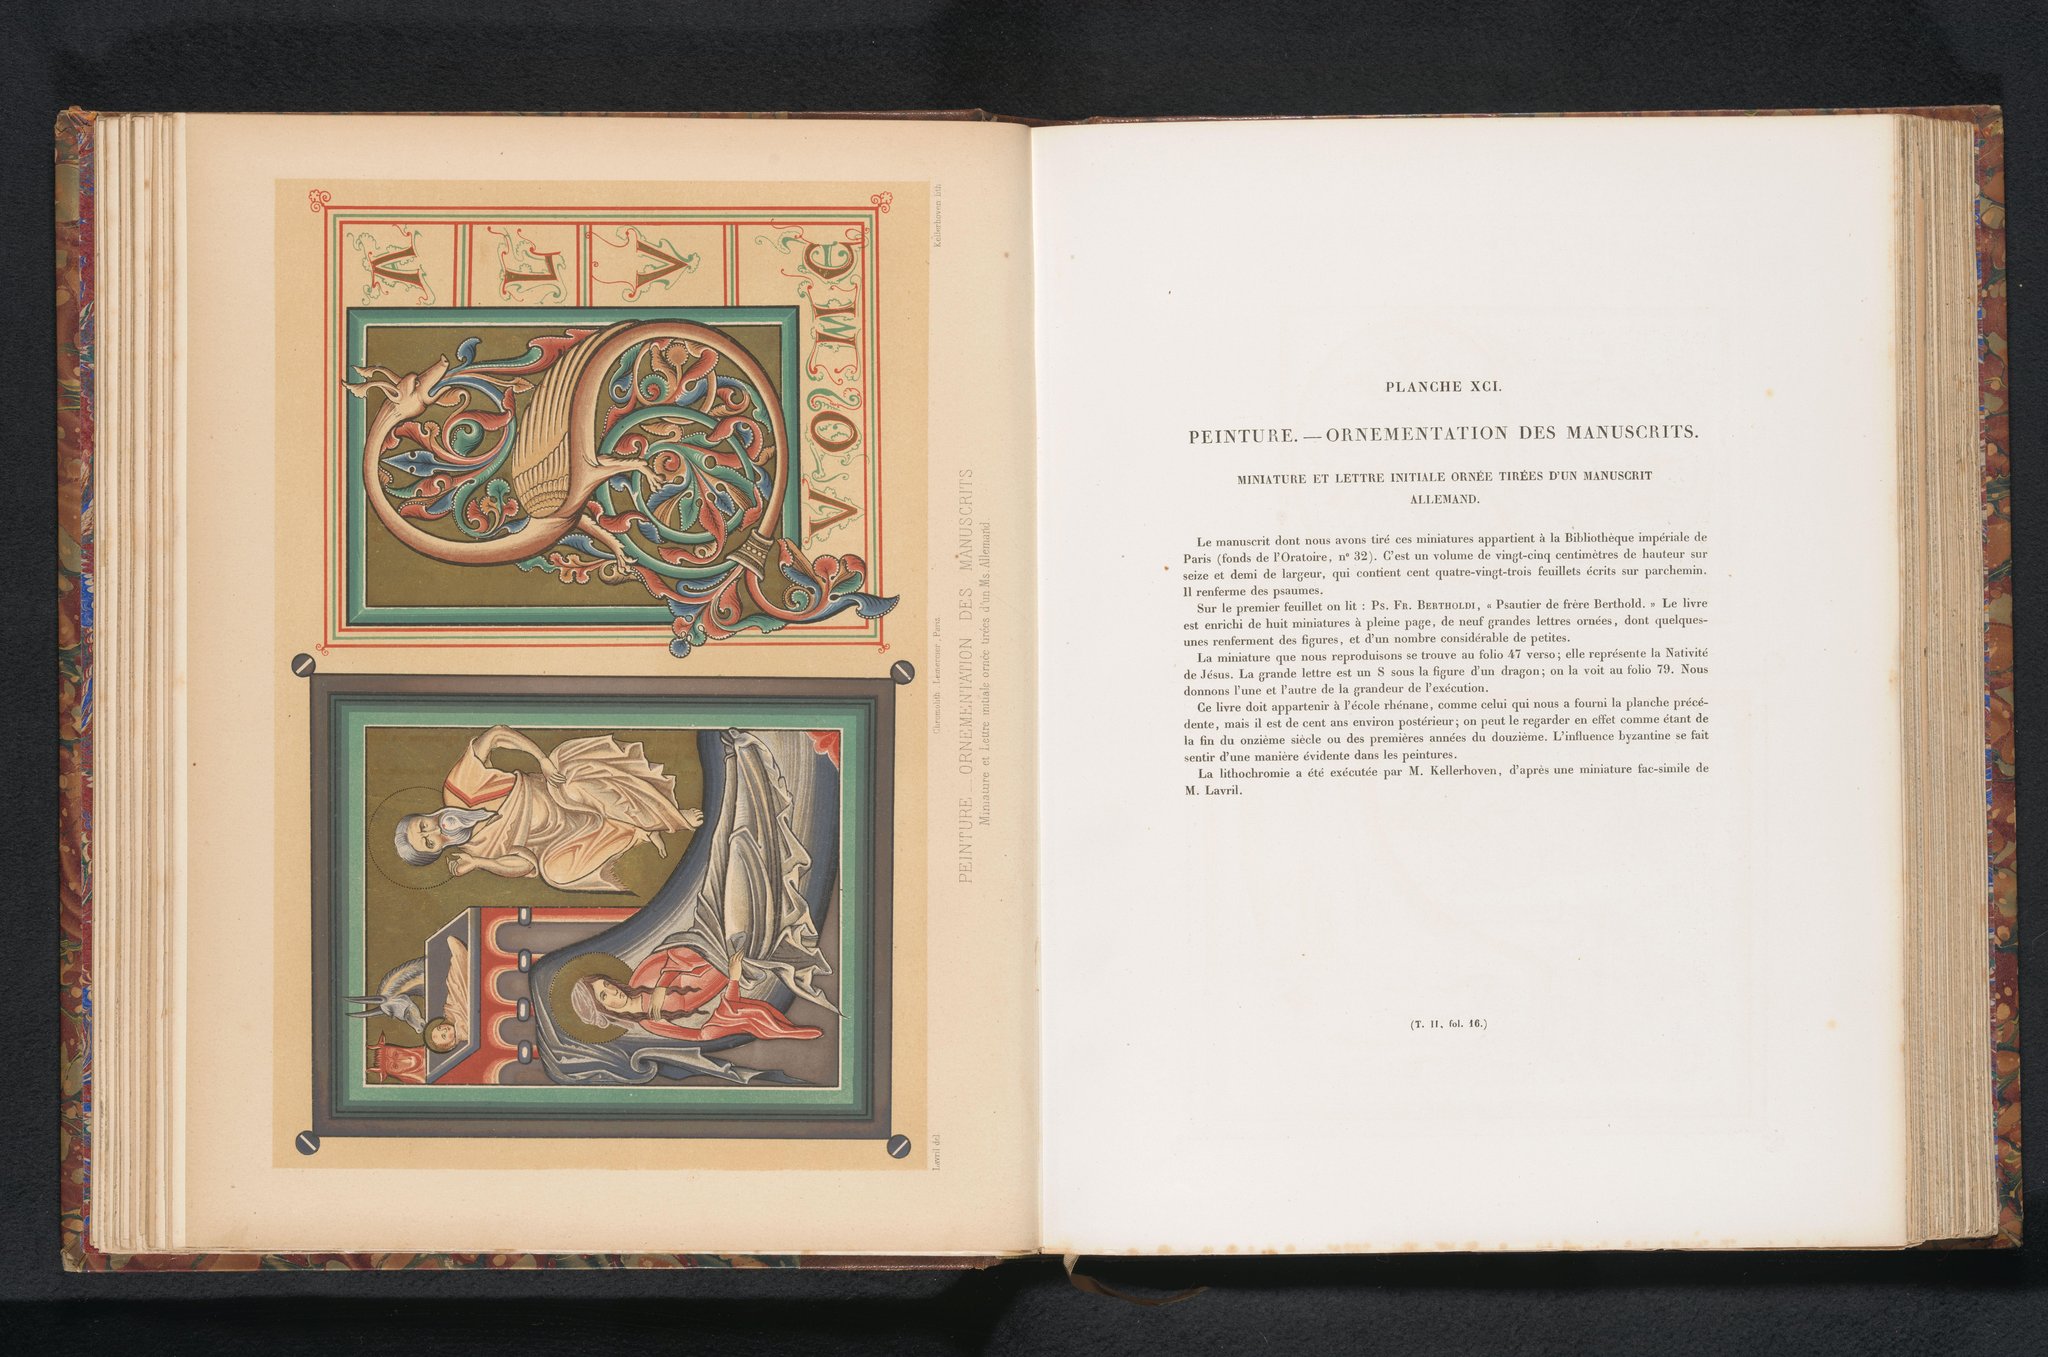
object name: reproduction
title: Miniature et Lettre initiale ornée tirées d'un Ms. Allemand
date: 1859-1864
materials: paper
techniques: chromolithography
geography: paris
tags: painting (including book-illumination, miniature-painting), birth and youth of christ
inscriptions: name: ‘Lavril del./ Kellerhoven lith.’